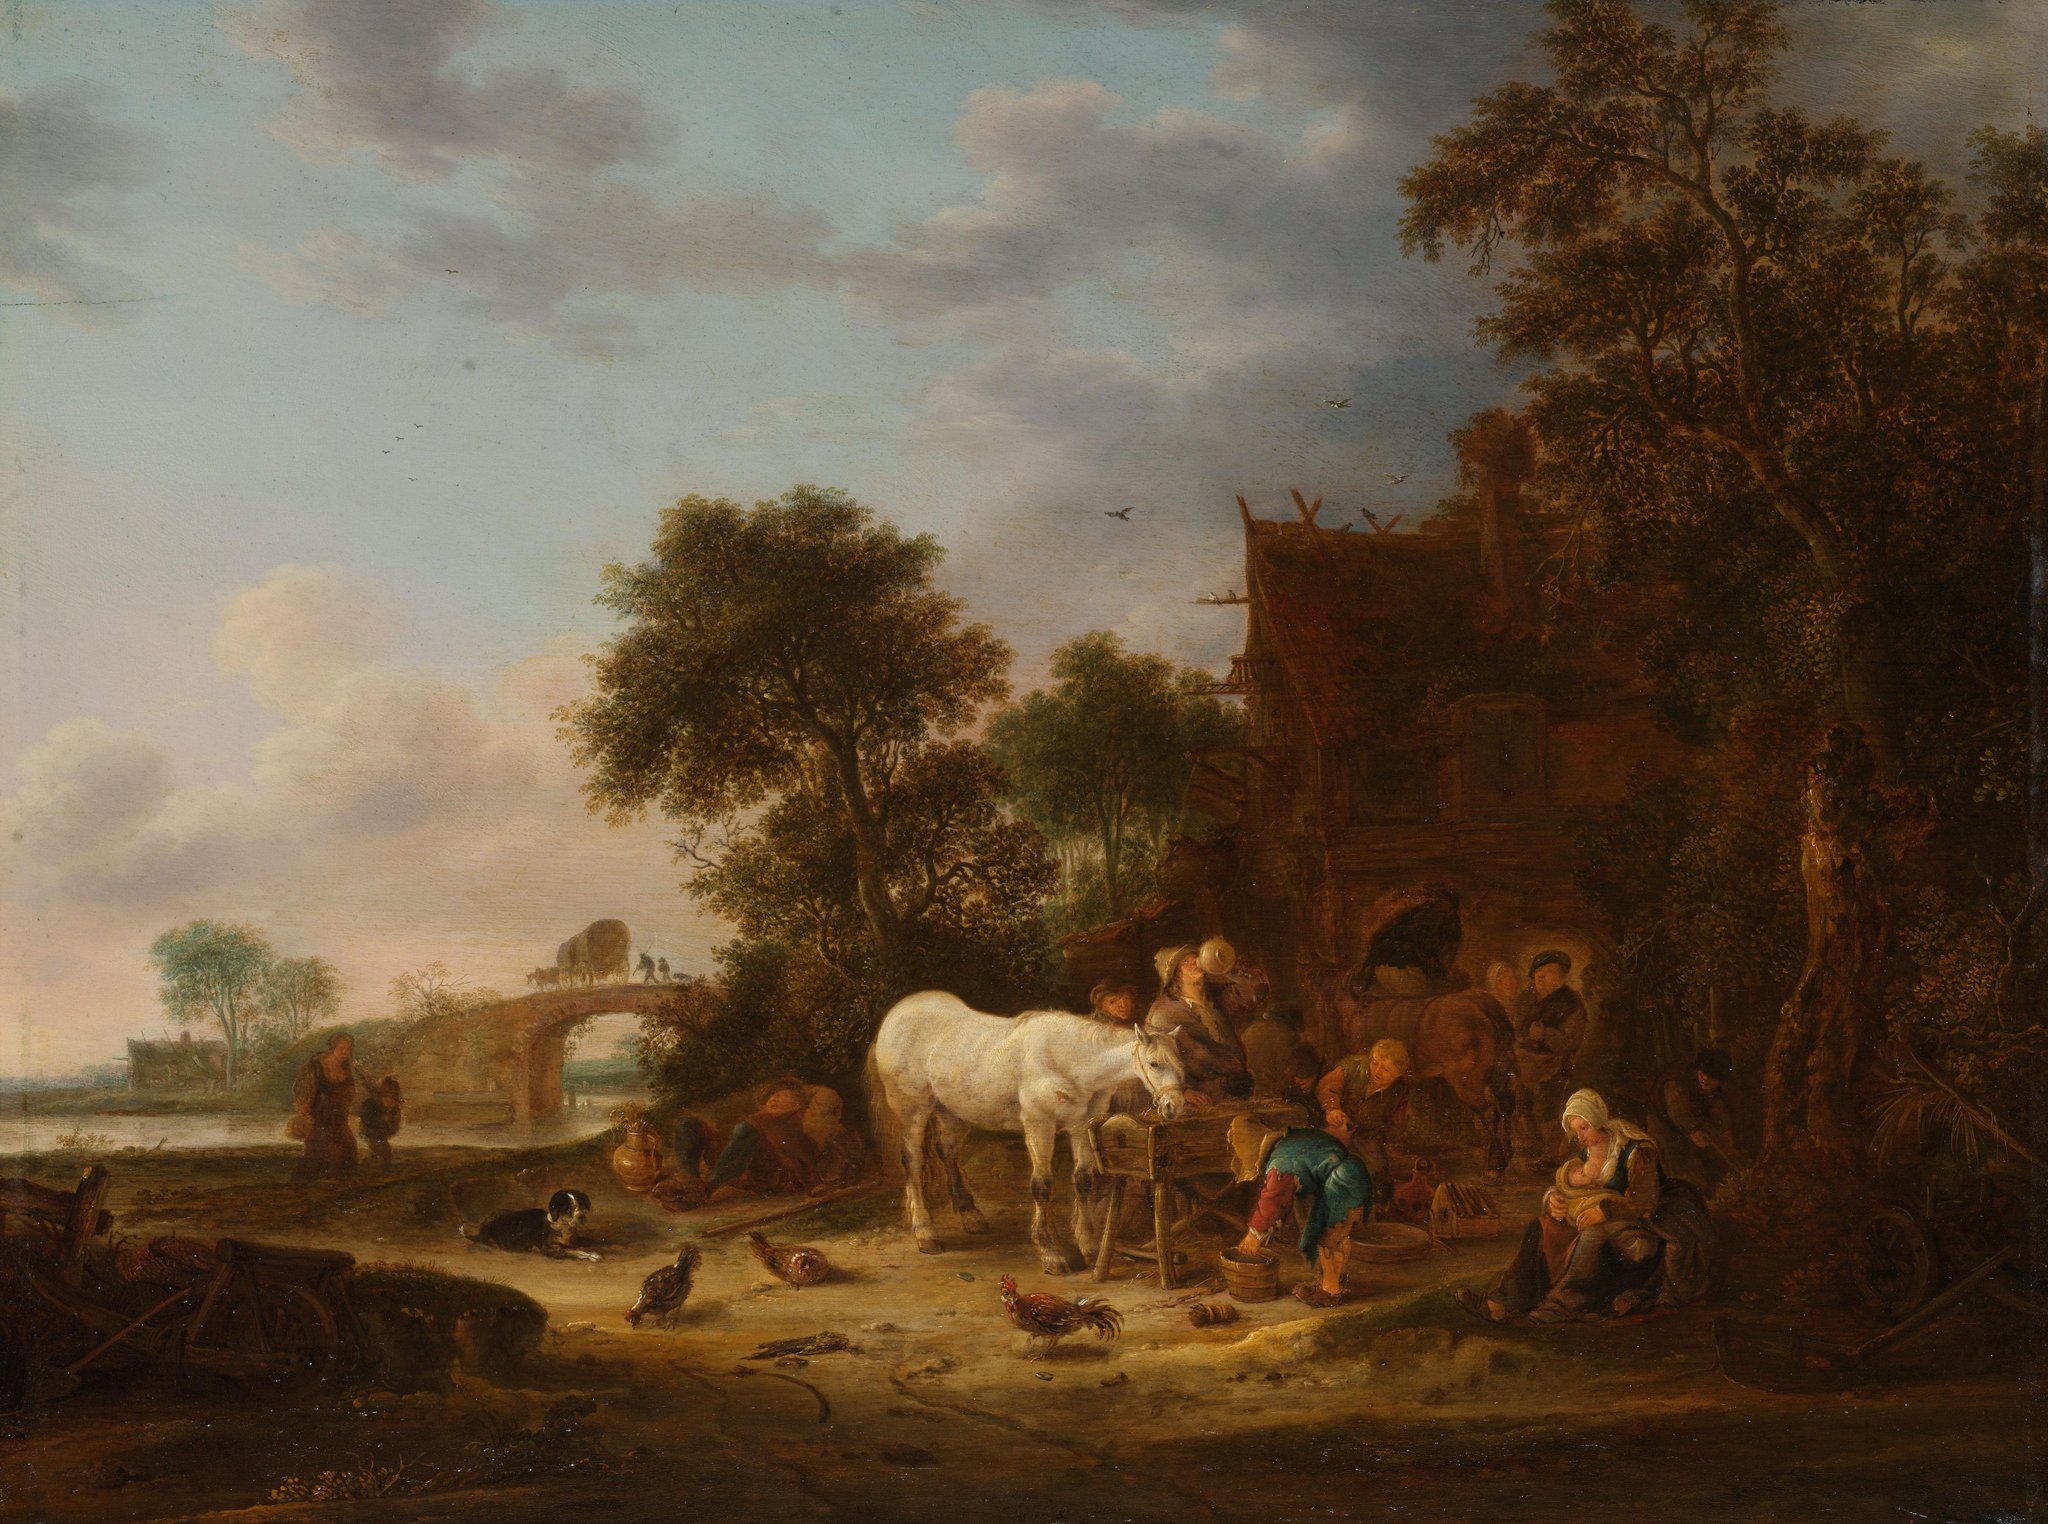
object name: painting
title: Country inn with a horse at the trough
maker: isaac van ostade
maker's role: draughtsman, painter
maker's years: 1621-1649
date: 1643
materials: oil, panel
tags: breasts giving milk - aa - female human figure, fowl (cock, hen, chicken, etc.), horse, farm or solitary house in landscape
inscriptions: signature and date: ‘Isack. van Ostade 1643’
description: Boerenherberg met paard aan de trog. Buiten voor een herberg worden paarden verzorgd en rusten reizigers. Rechts geeft een vrouw haar kind de borst, op de voorgrond scharrelen kippen, links zit een hond bij een slapende man.